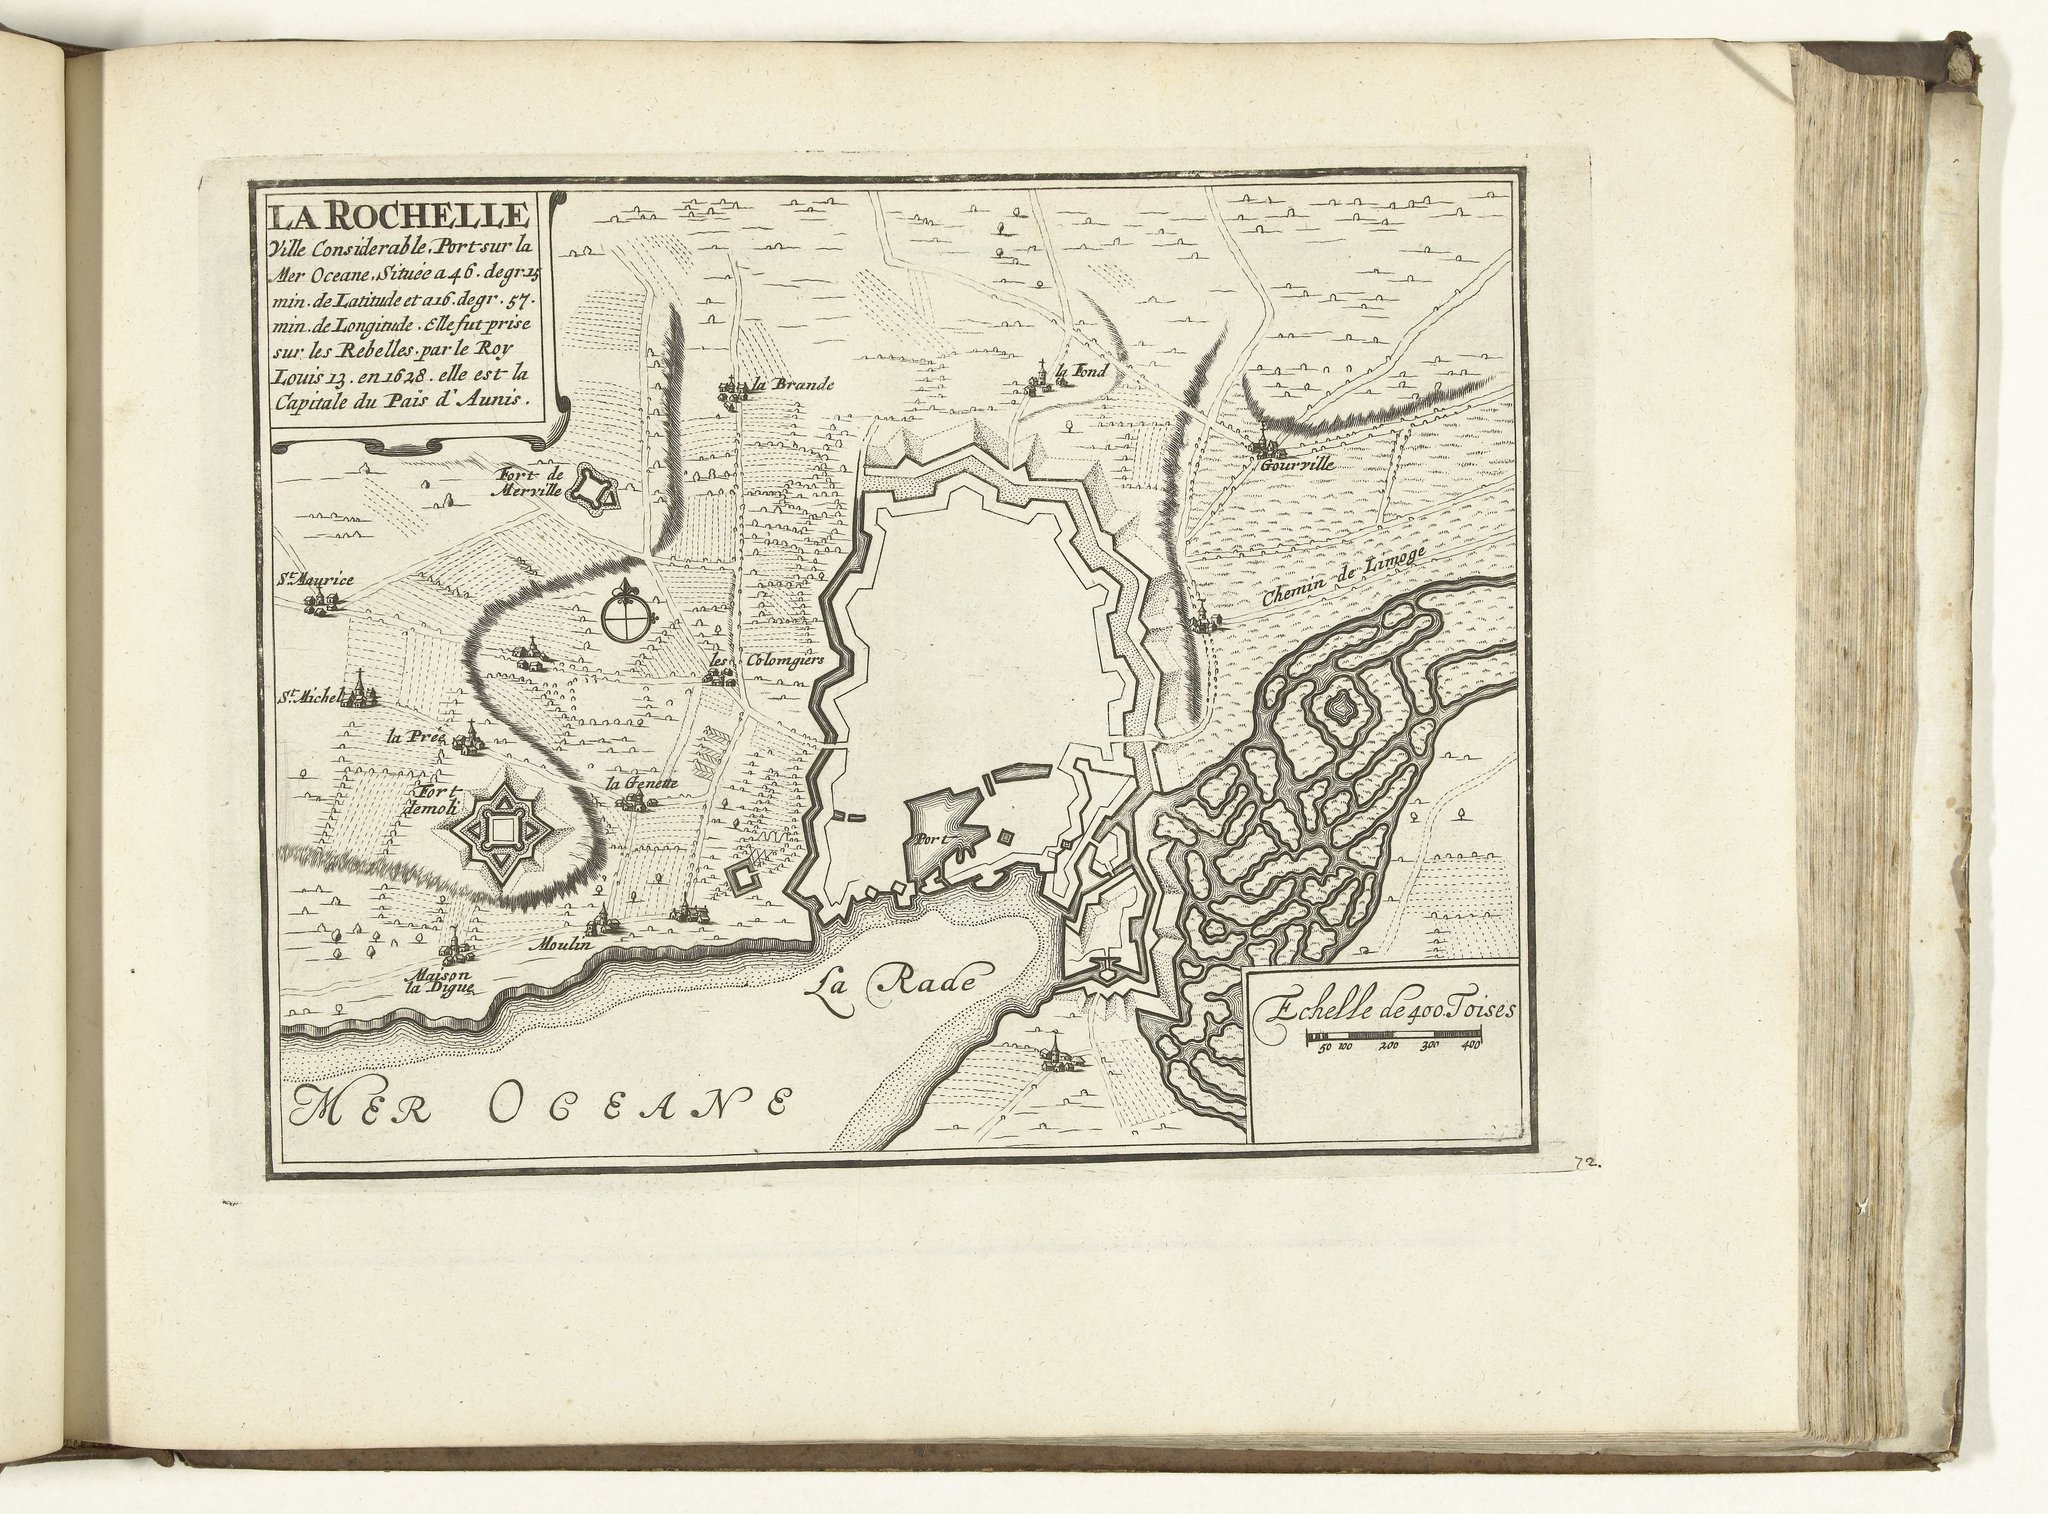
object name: print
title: Plattegrond van La Rochelle, 1726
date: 1726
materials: paper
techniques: engraving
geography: northern netherlands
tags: fortress, maps of cities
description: Plattegrond van de versterkingen om de Franse stad La Rochelle. Plaat nr. 72 in deel IV van het prentwerk: Les Forces de l'Europe, Asie, Afrique et Amerique ... Comme aussi les Cartes des Côtes de France et d'Espagne uit 1726, dit eerste deel met 238 met de hand genummerde platen van vermaarde sterke steden en vestingen in het kader van de Spaanse Successieoorlog 1701-1713. Voor het merendeel zijn deze platen gekopieerd naar de anonieme Franse platen van vermaarde sterke steden en vestingen: in Les forces de l'Europe en in: Le theatre de la guerre, dans les Pays-Bas, beide oorspronkelijk uitgegeven door Nicolas de Fer te Parijs (1693-1697) in het kader van de Negenjarige Oorlog. Titel en opschriften in het Frans.